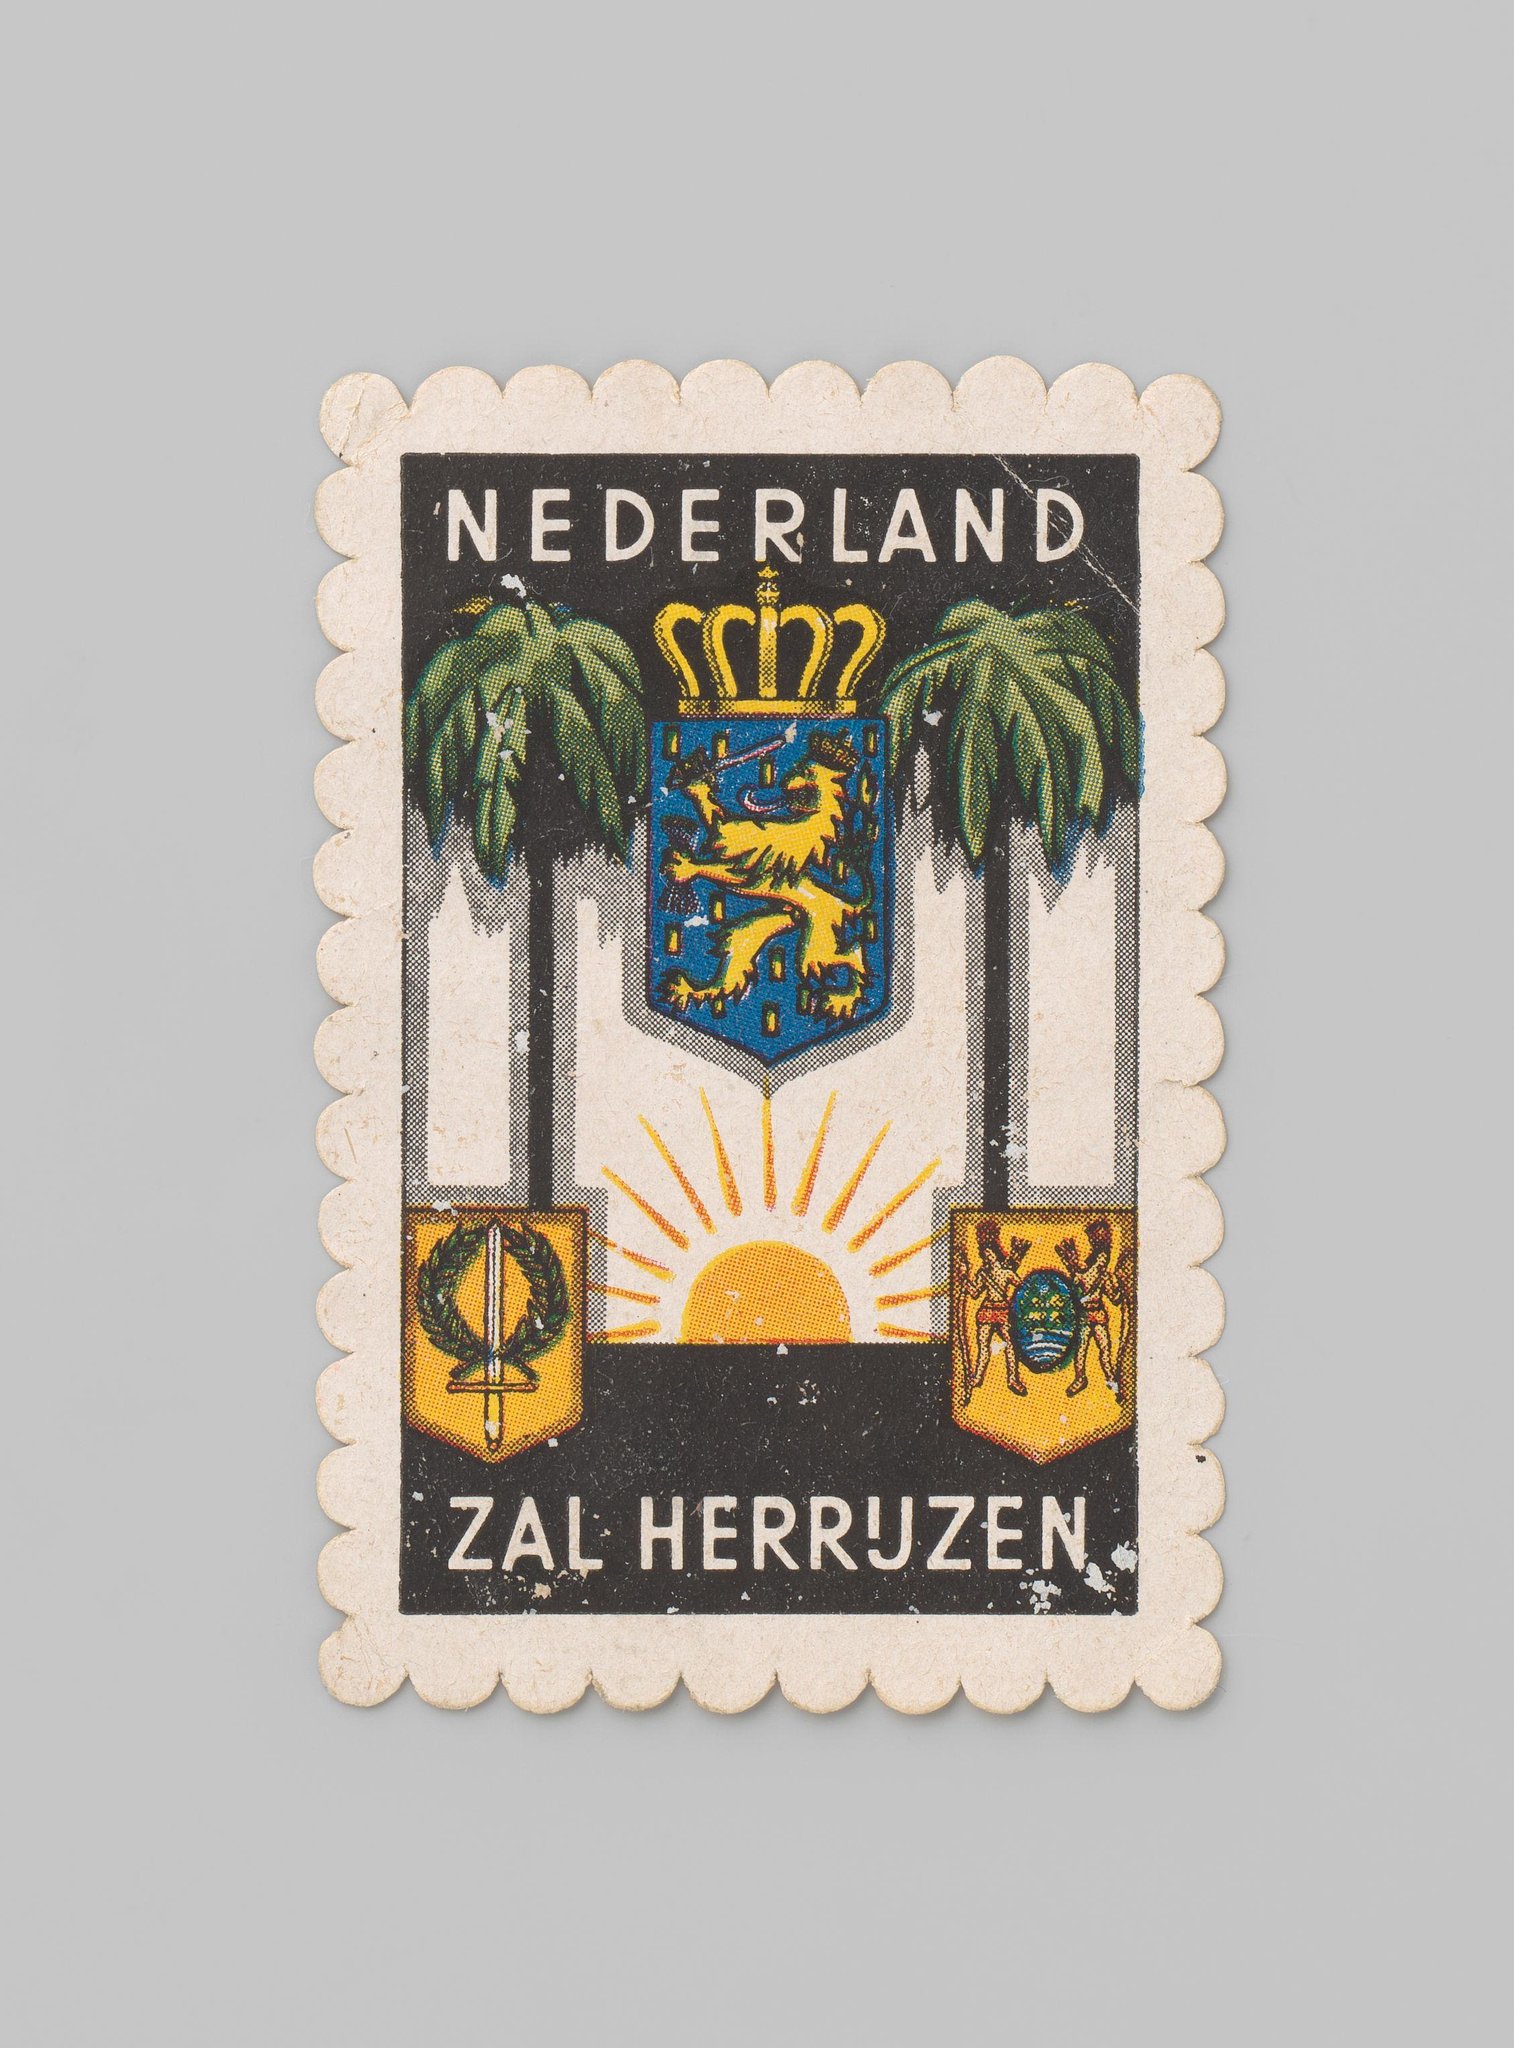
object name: sluitzegel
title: Plakzegel Nederland zal herrijzen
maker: Anonymous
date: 1905-1940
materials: paper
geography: batavia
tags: netherlands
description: "Plakzegel Nederland zal herrijzen; in Batavia gedrukt omstreeks mei 1940." [Beschrijving Wim Schüller, Inventaris van de Grogoldoos, 1994/5]